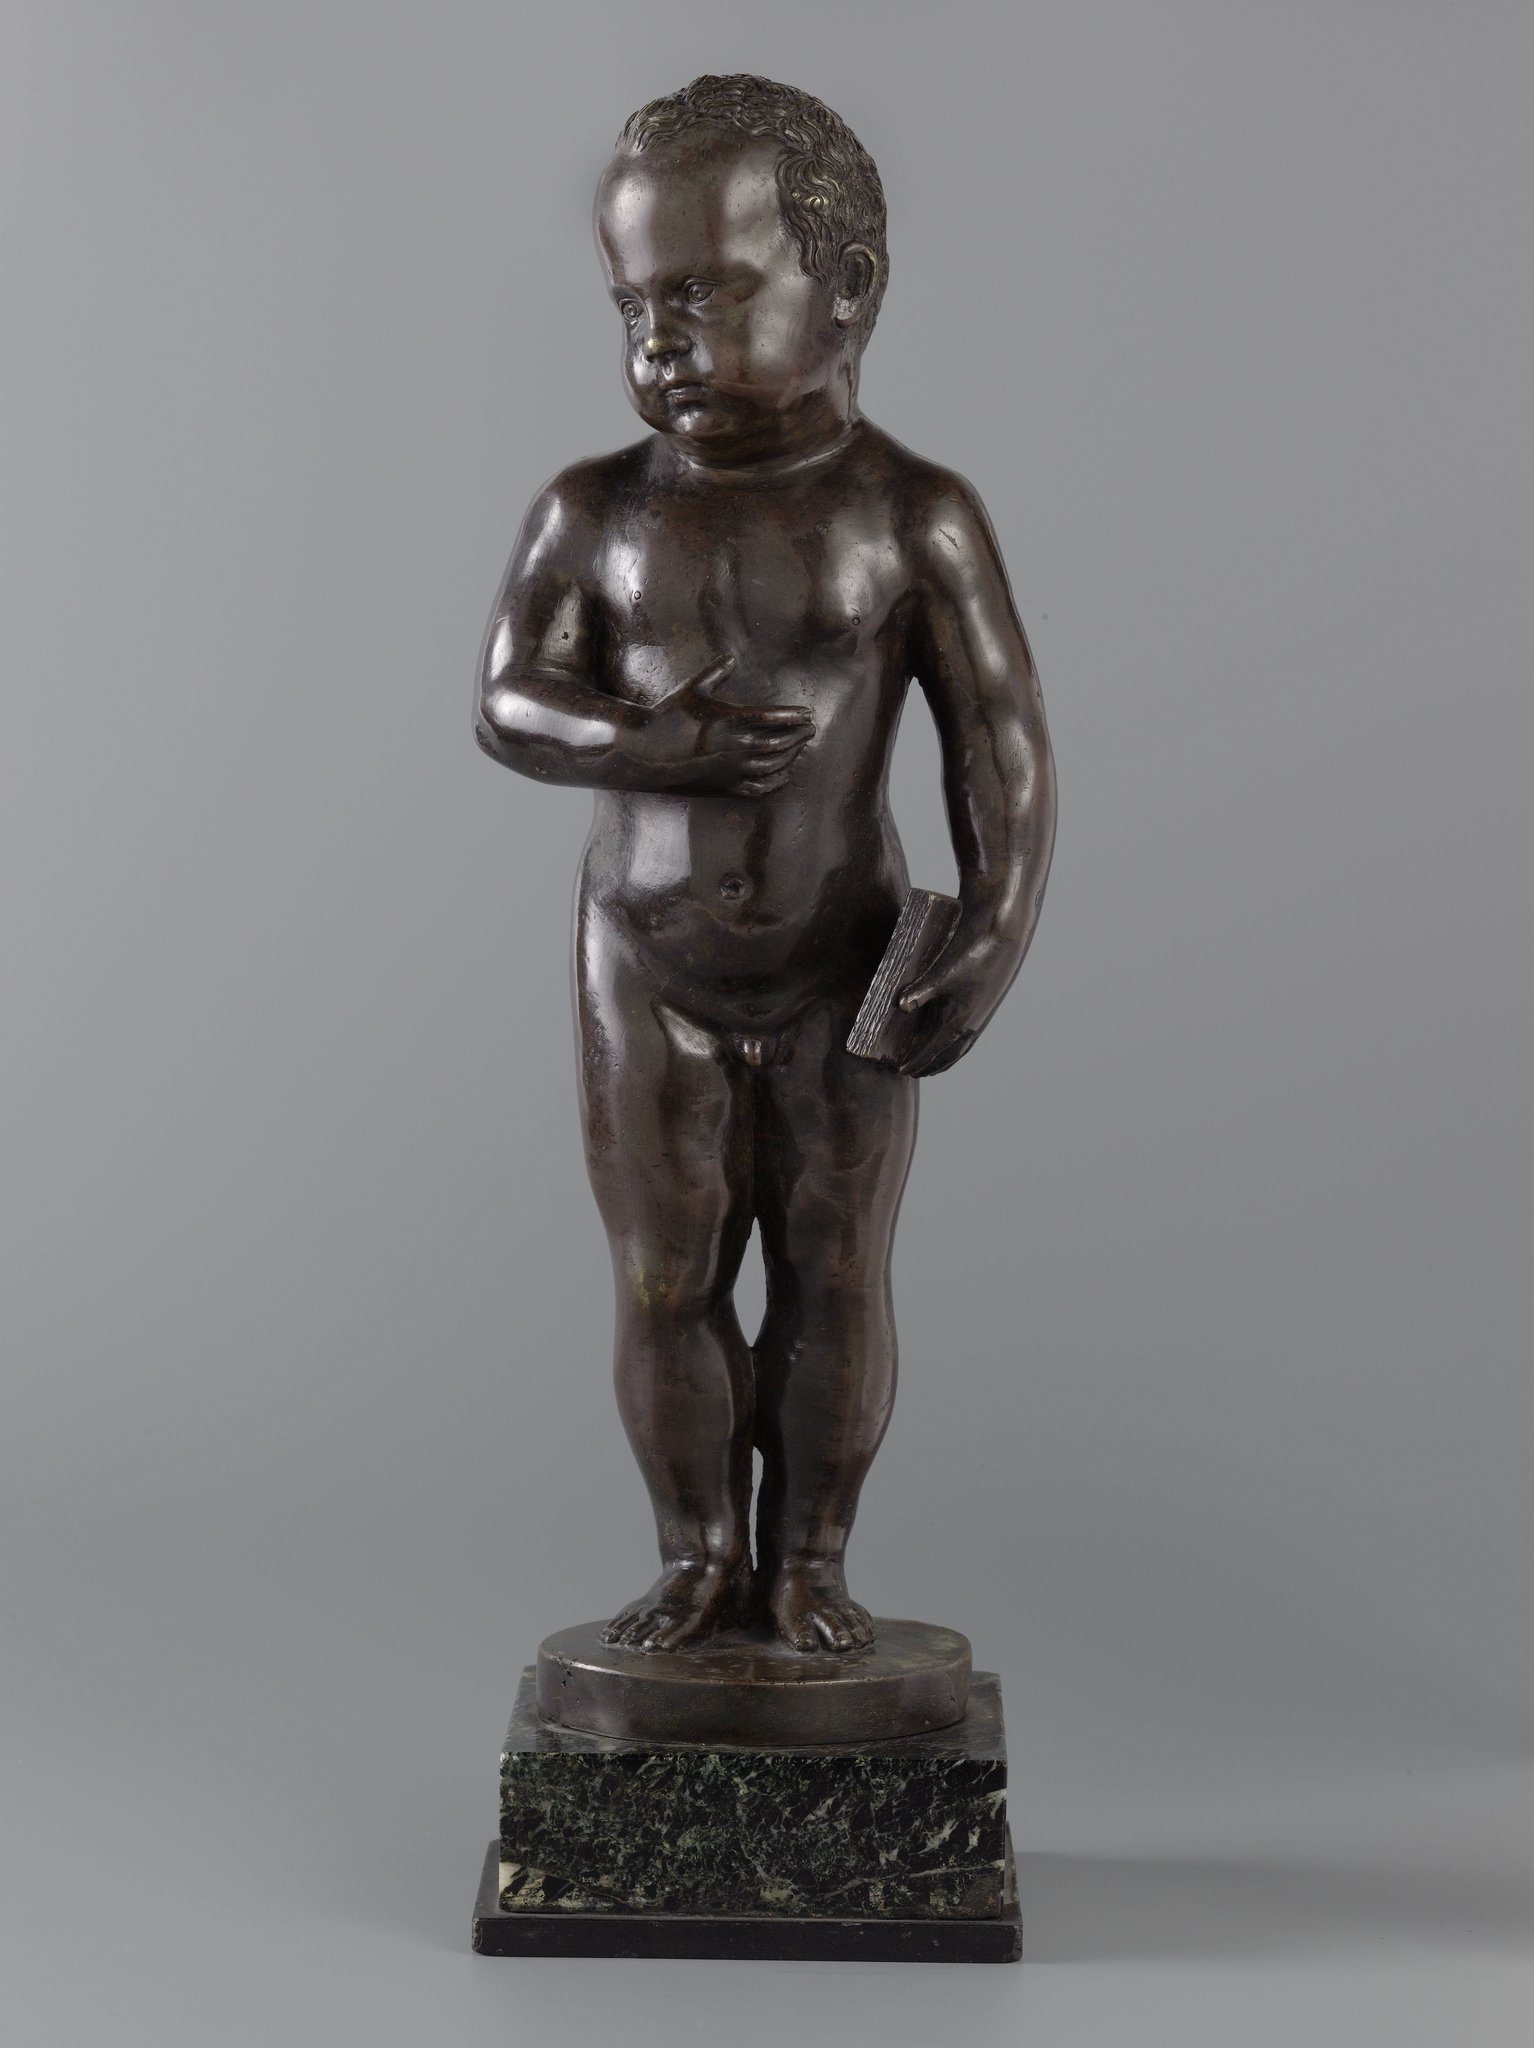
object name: sculpture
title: Knaap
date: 1500-1525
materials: bronze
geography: northern italy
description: Boy. Bronze. Northern Italy or Southern Germany, c. 1500 - 1530.